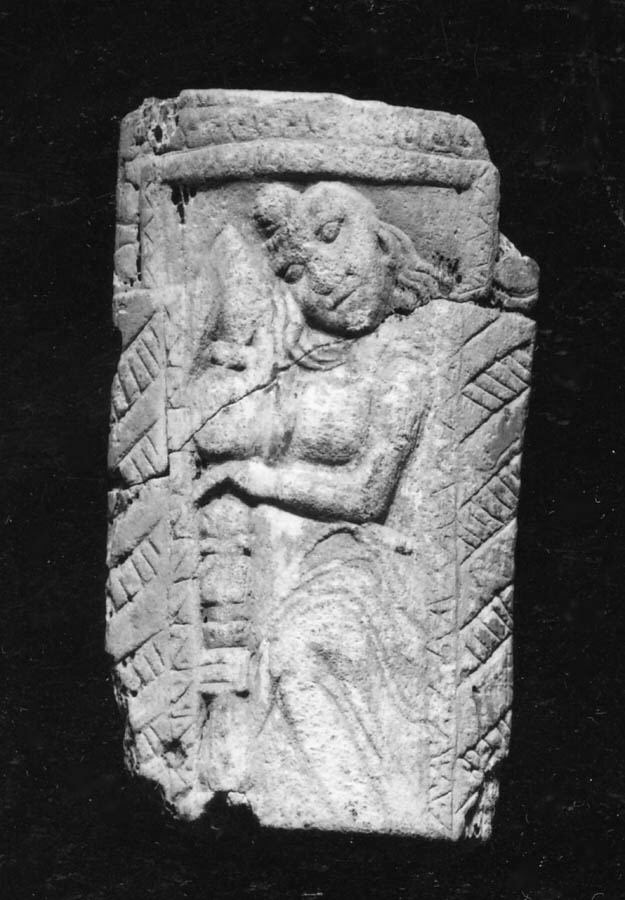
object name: plaque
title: Plaque with a Figure Standing in a Doorway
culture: gandhara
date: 101-200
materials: bone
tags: satavahana,women